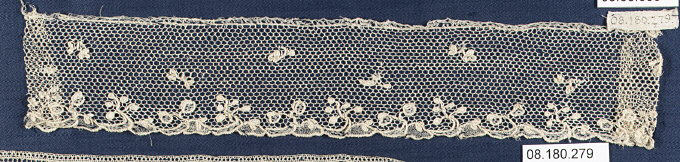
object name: fragment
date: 1701-1800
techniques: lace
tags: leaves